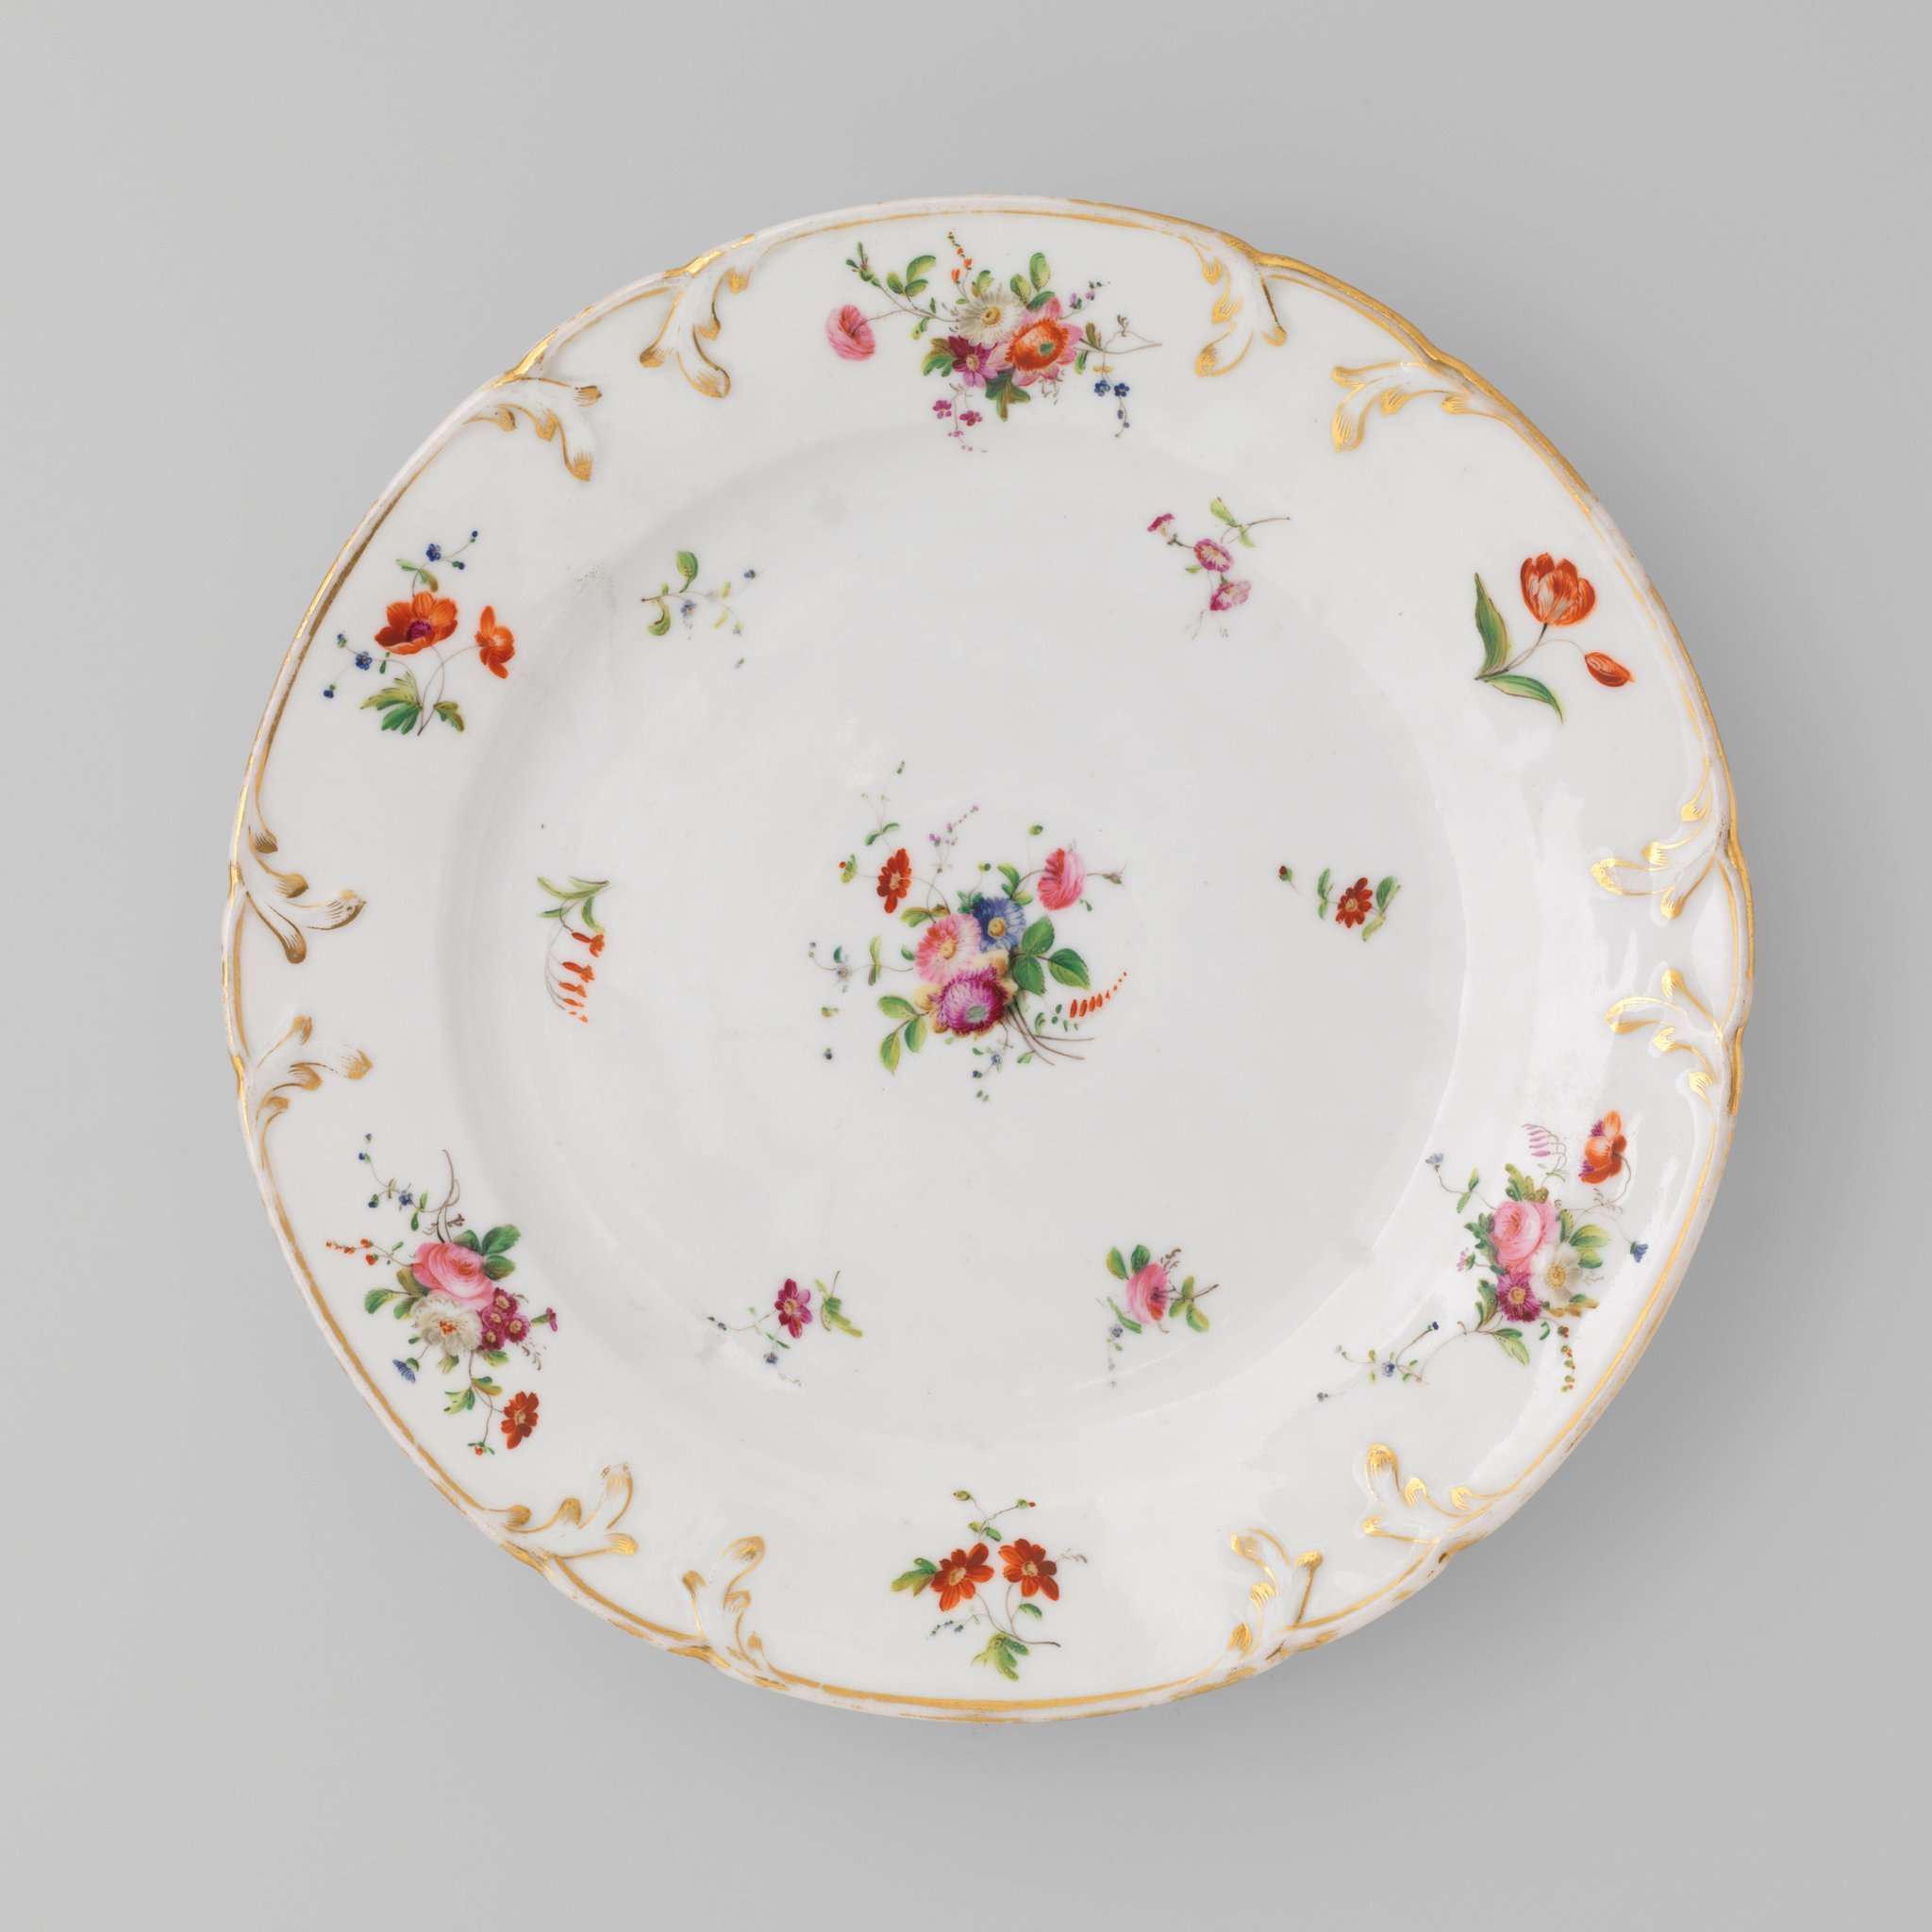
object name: service set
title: Dish with bouquets and flower sprays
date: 1839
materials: glaze, gold, paint, porcelain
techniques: firing, forming, gilding, turning, vitrification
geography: paris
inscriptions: mark: ‘DENUELLE/ Boulevard St. Denis 18/ à Paris’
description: Schotel van porselein met een gelobde rand, beschilderd op het glazuur in blauw, rood, roze, groen, geel, paars, zwart en goud. Op het plat boeketten van verschillende bloemen en strooibloemen. Vanuit de gelobde, gouden rand, gemodelleerde bladranken in reliëf, aangezet met goud. Hiertussen boeketten. Dubbele voetring. Gemerkt op de onderzijde met 'DENUELLE/ Boulevard St. Denis 18/ à Paris'.